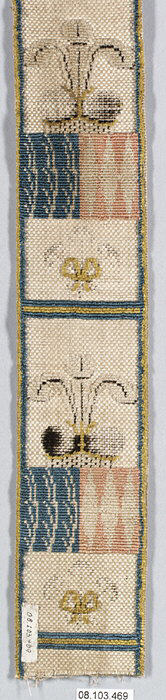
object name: galloon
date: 1601-1800